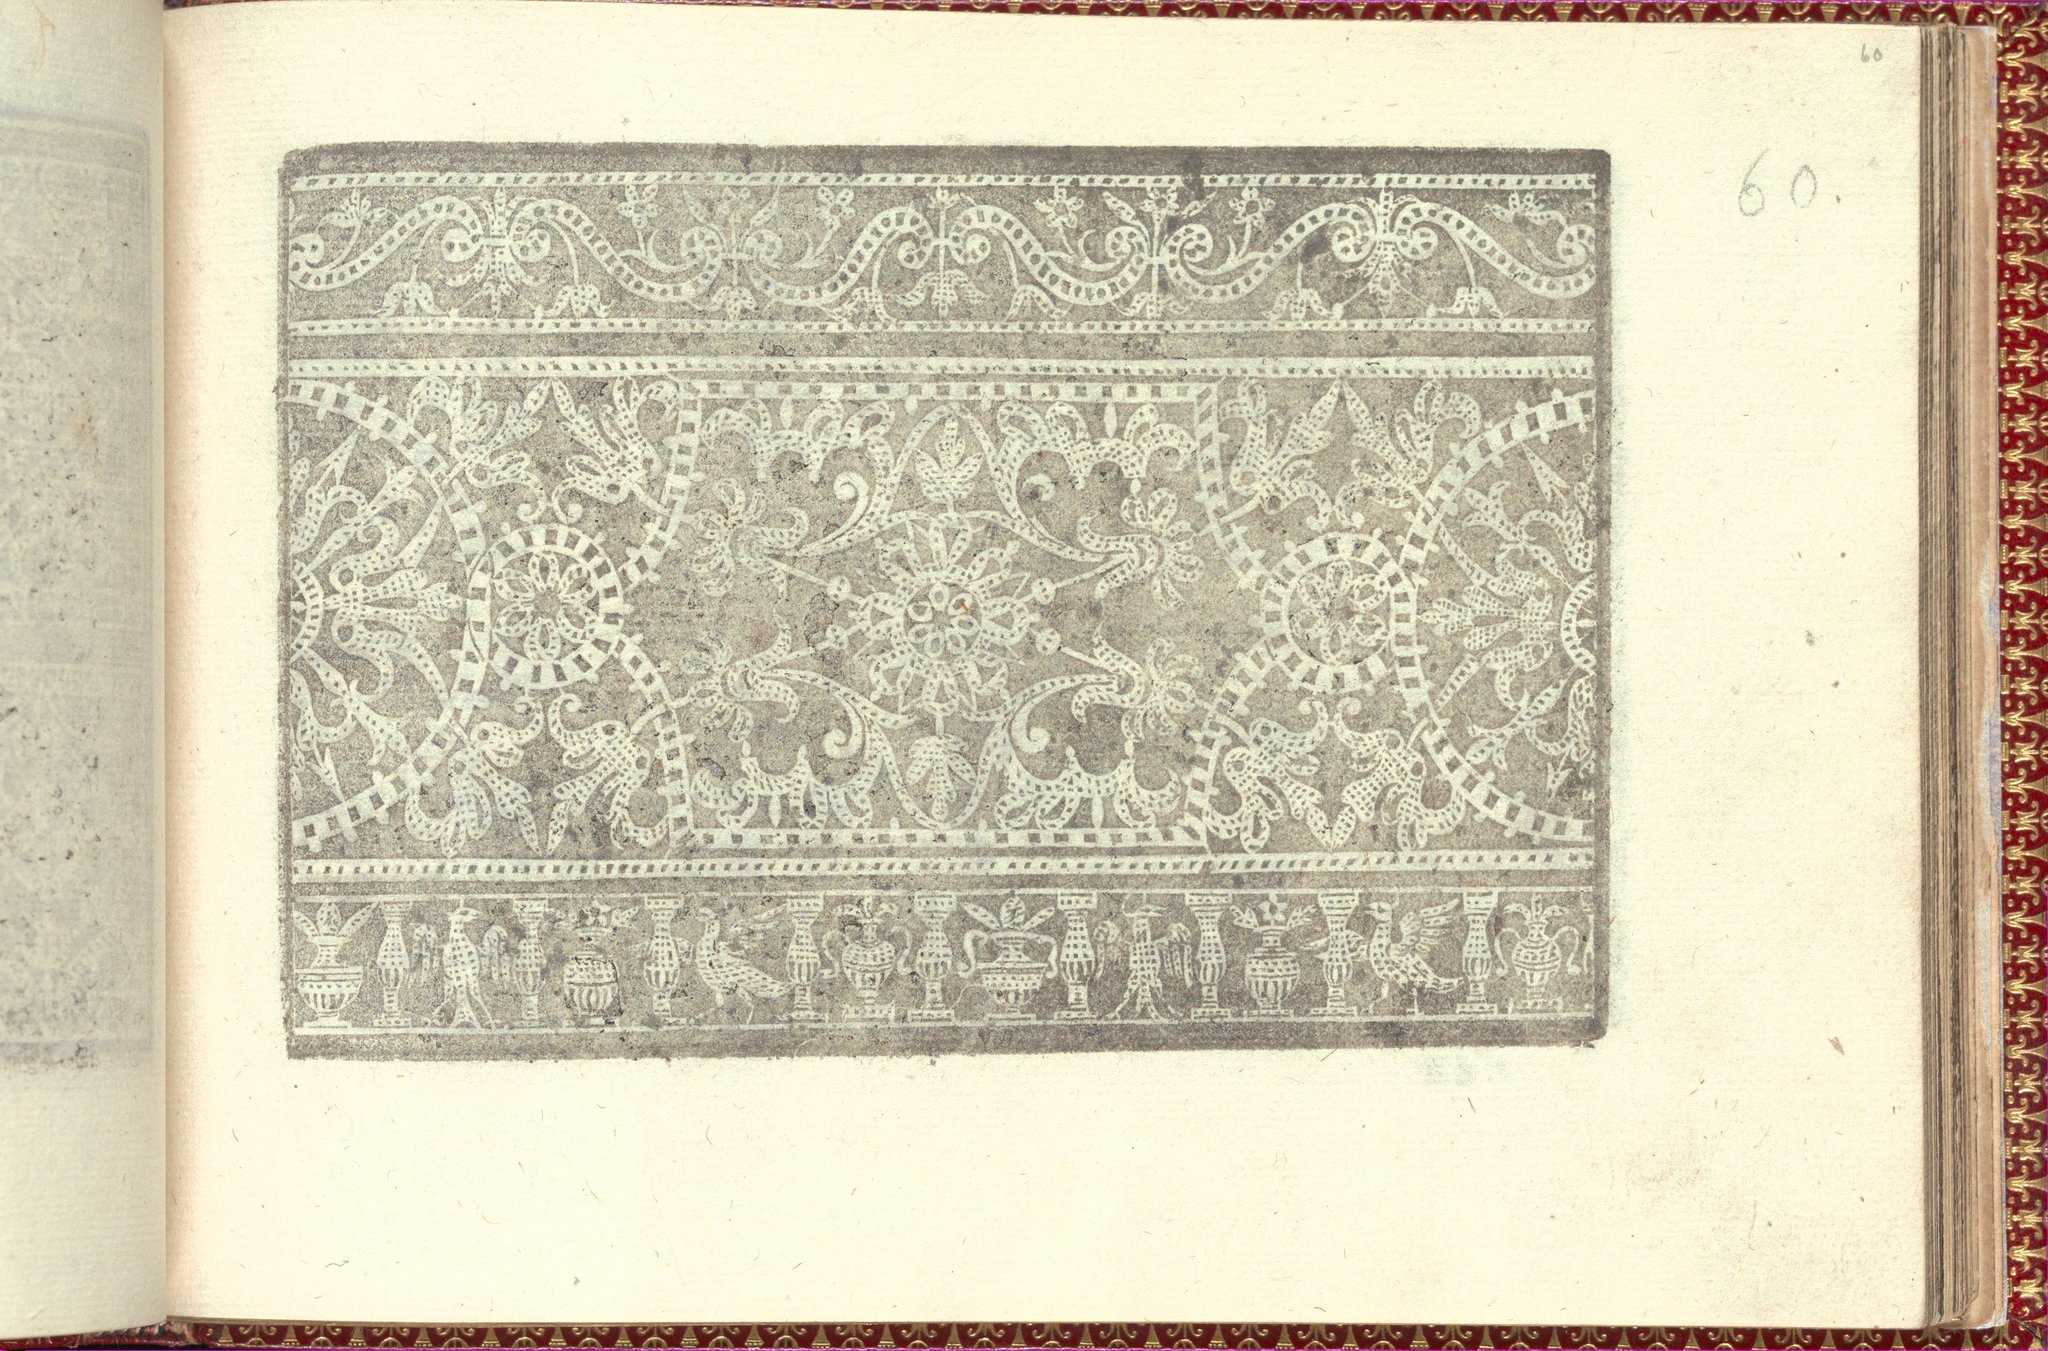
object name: book print ornament architecture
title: Corona delle Nobili et Virtuose Donne: Libro I-IV, page 60 (recto)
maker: cesare vecellio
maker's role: publisher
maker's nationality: italian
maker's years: 1521-1601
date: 1601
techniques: woodcut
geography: italy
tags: flowers